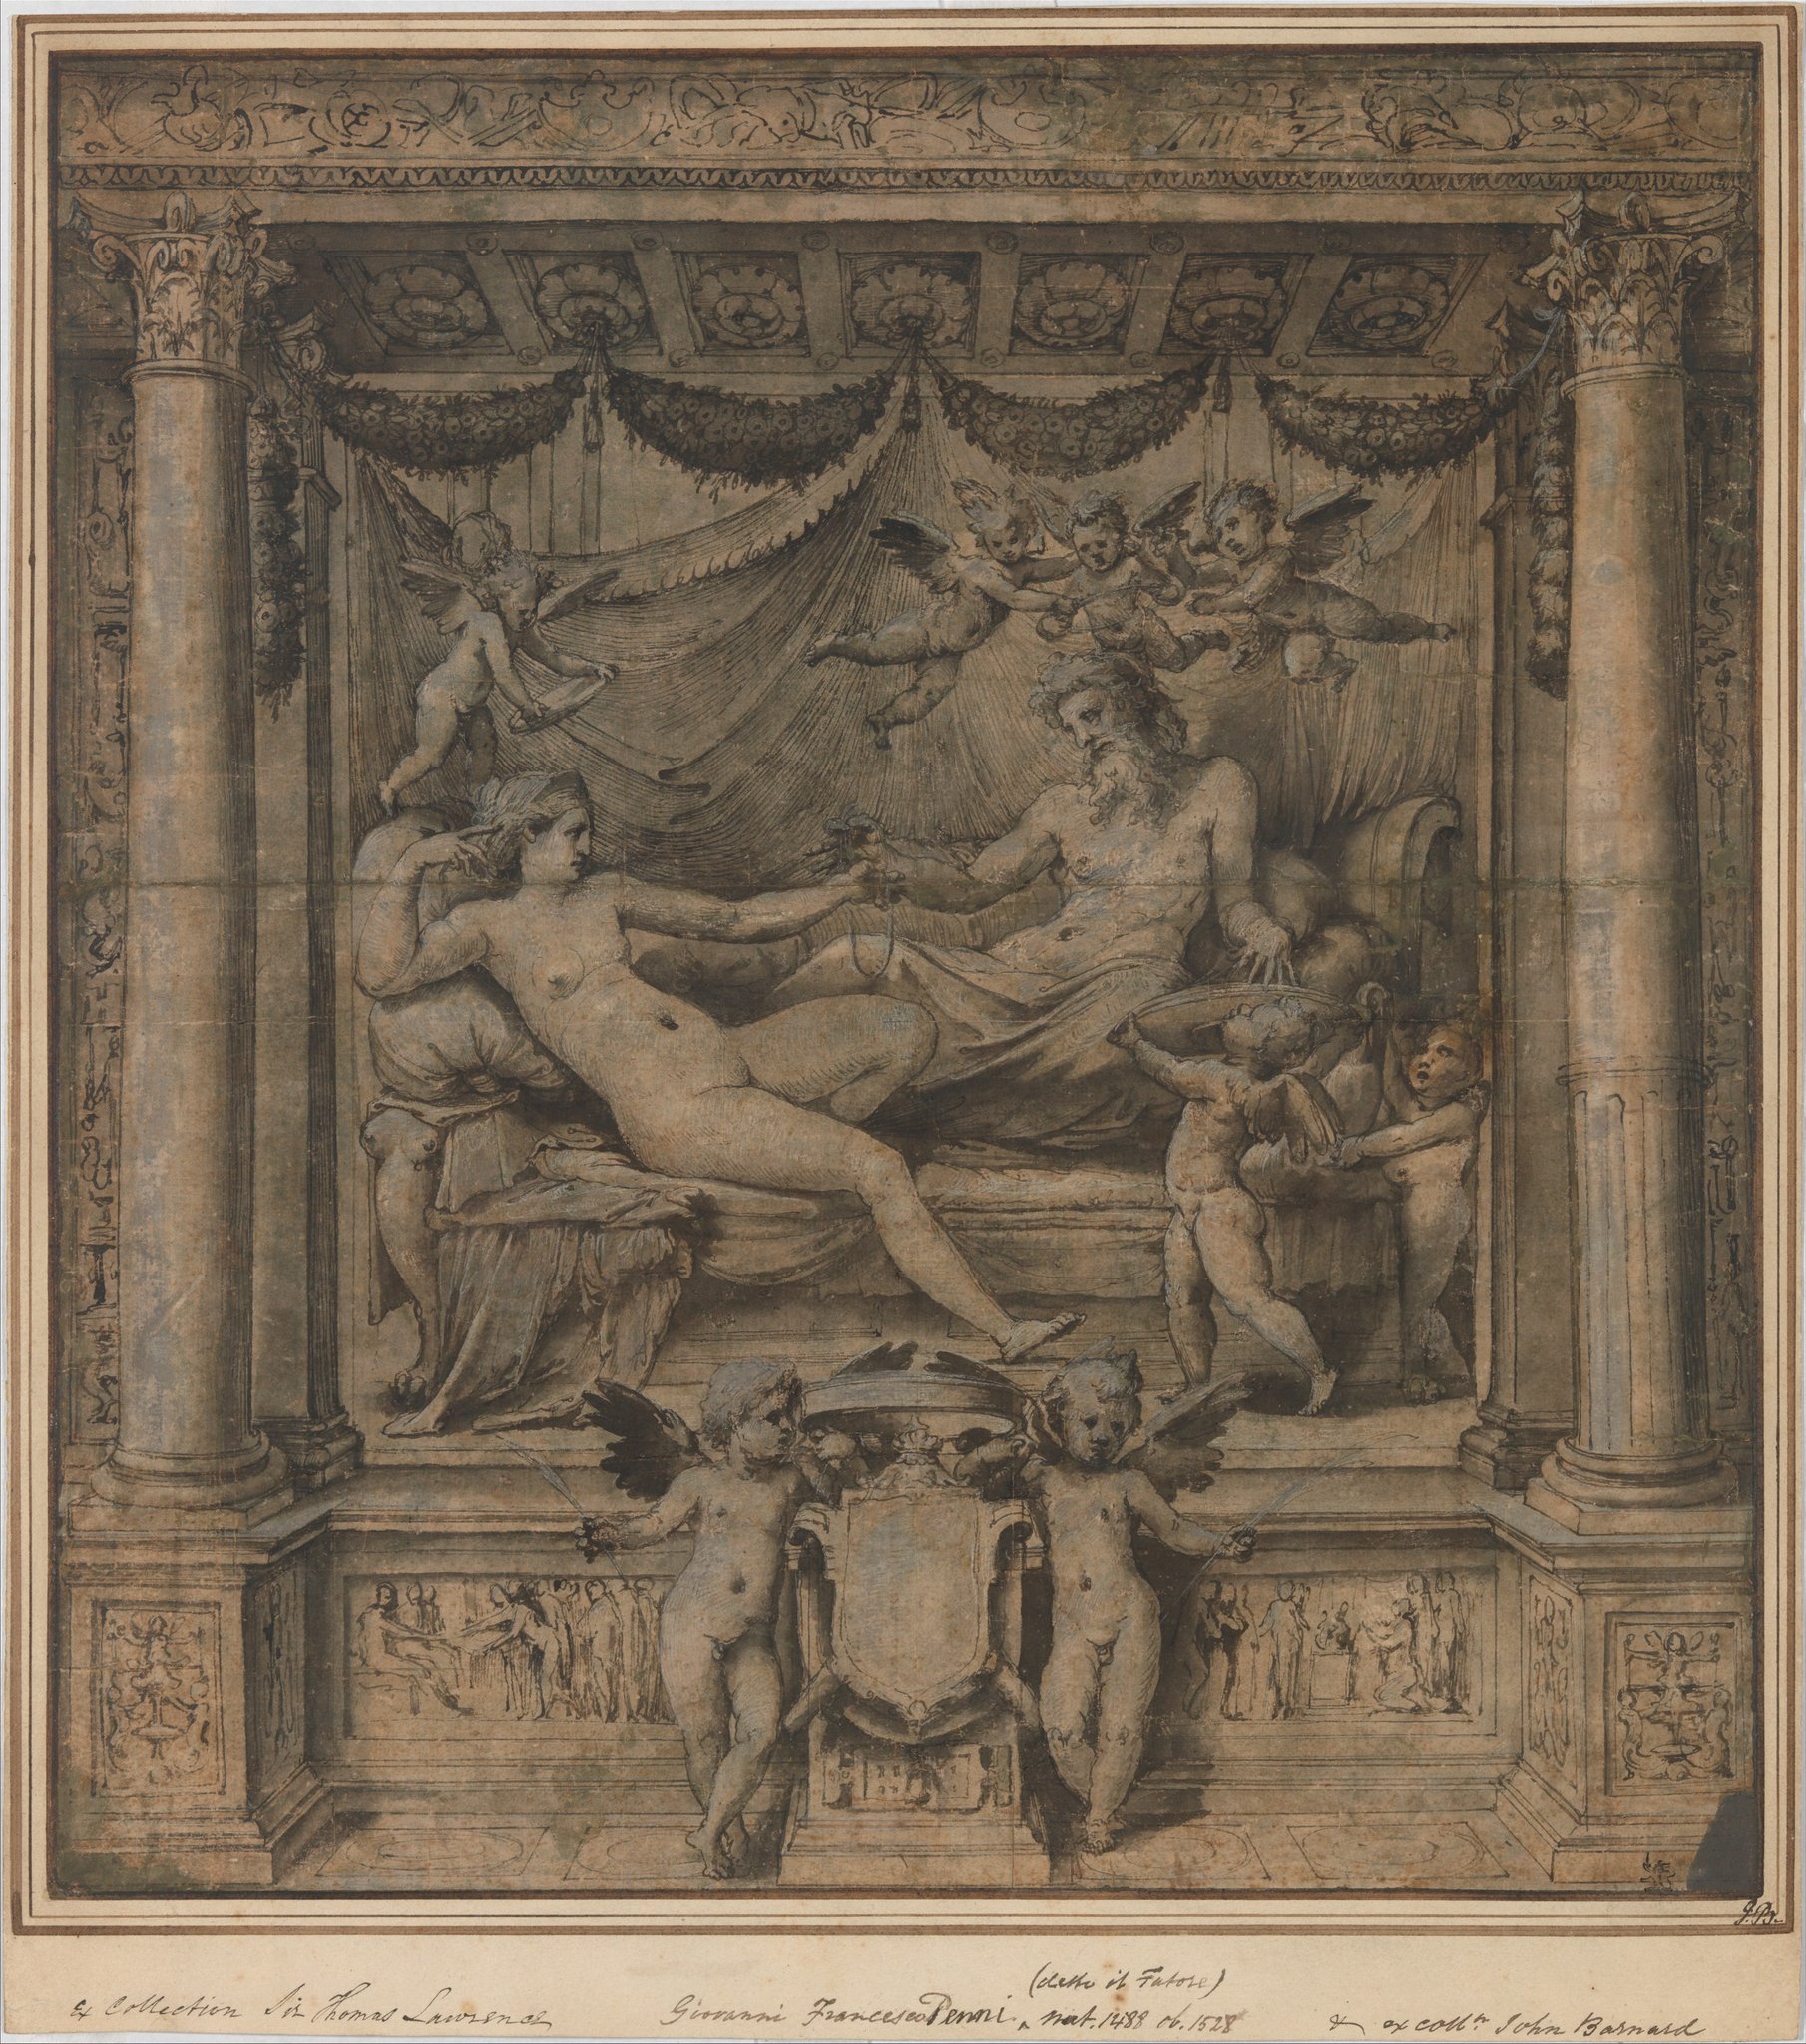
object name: drawing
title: Jupiter and Juno: Study for the "Furti di Giove" Tapestries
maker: perino del vaga (pietro buonaccorsi)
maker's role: artist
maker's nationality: italian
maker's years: 1501-1547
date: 1532-1535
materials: gouache, ink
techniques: brush, highlighting, pen, wash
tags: putti,juno,jupiter,beds